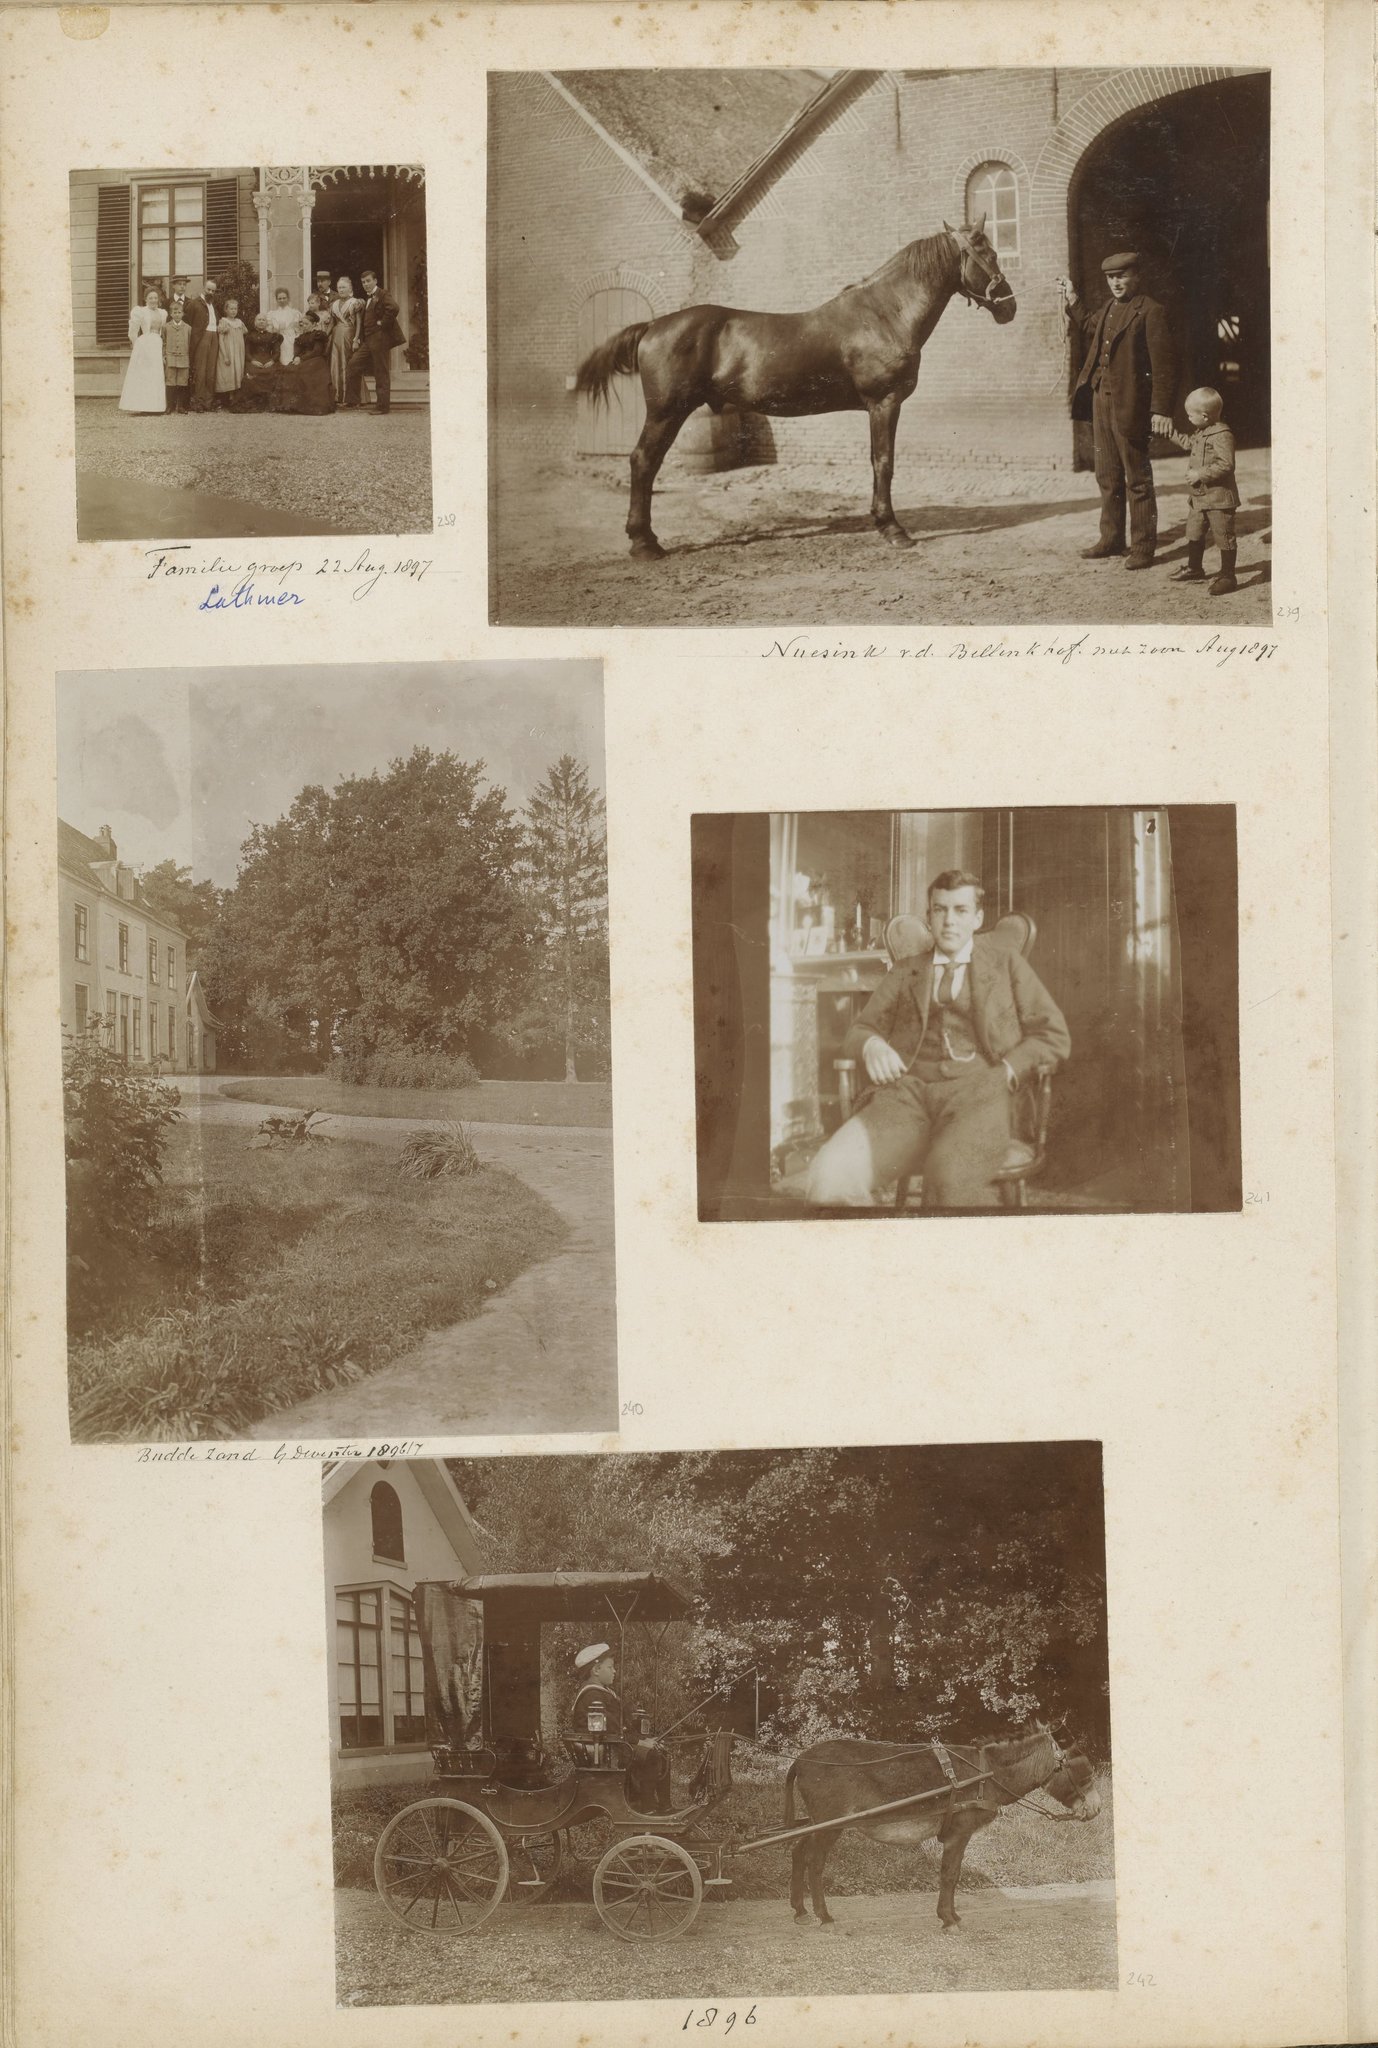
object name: album leaf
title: Jongen in matrozenpak zittend op de bok van een ezelkar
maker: Anonymous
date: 1896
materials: paper, photographic support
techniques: collodion silver print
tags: ass, donkey, child, four-wheeled, animal-drawn vehicle, e.g.: cab, carriage, coach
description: Onderdeel van Fotoalbum van Robert Daniel Crommelin (1841-1907).